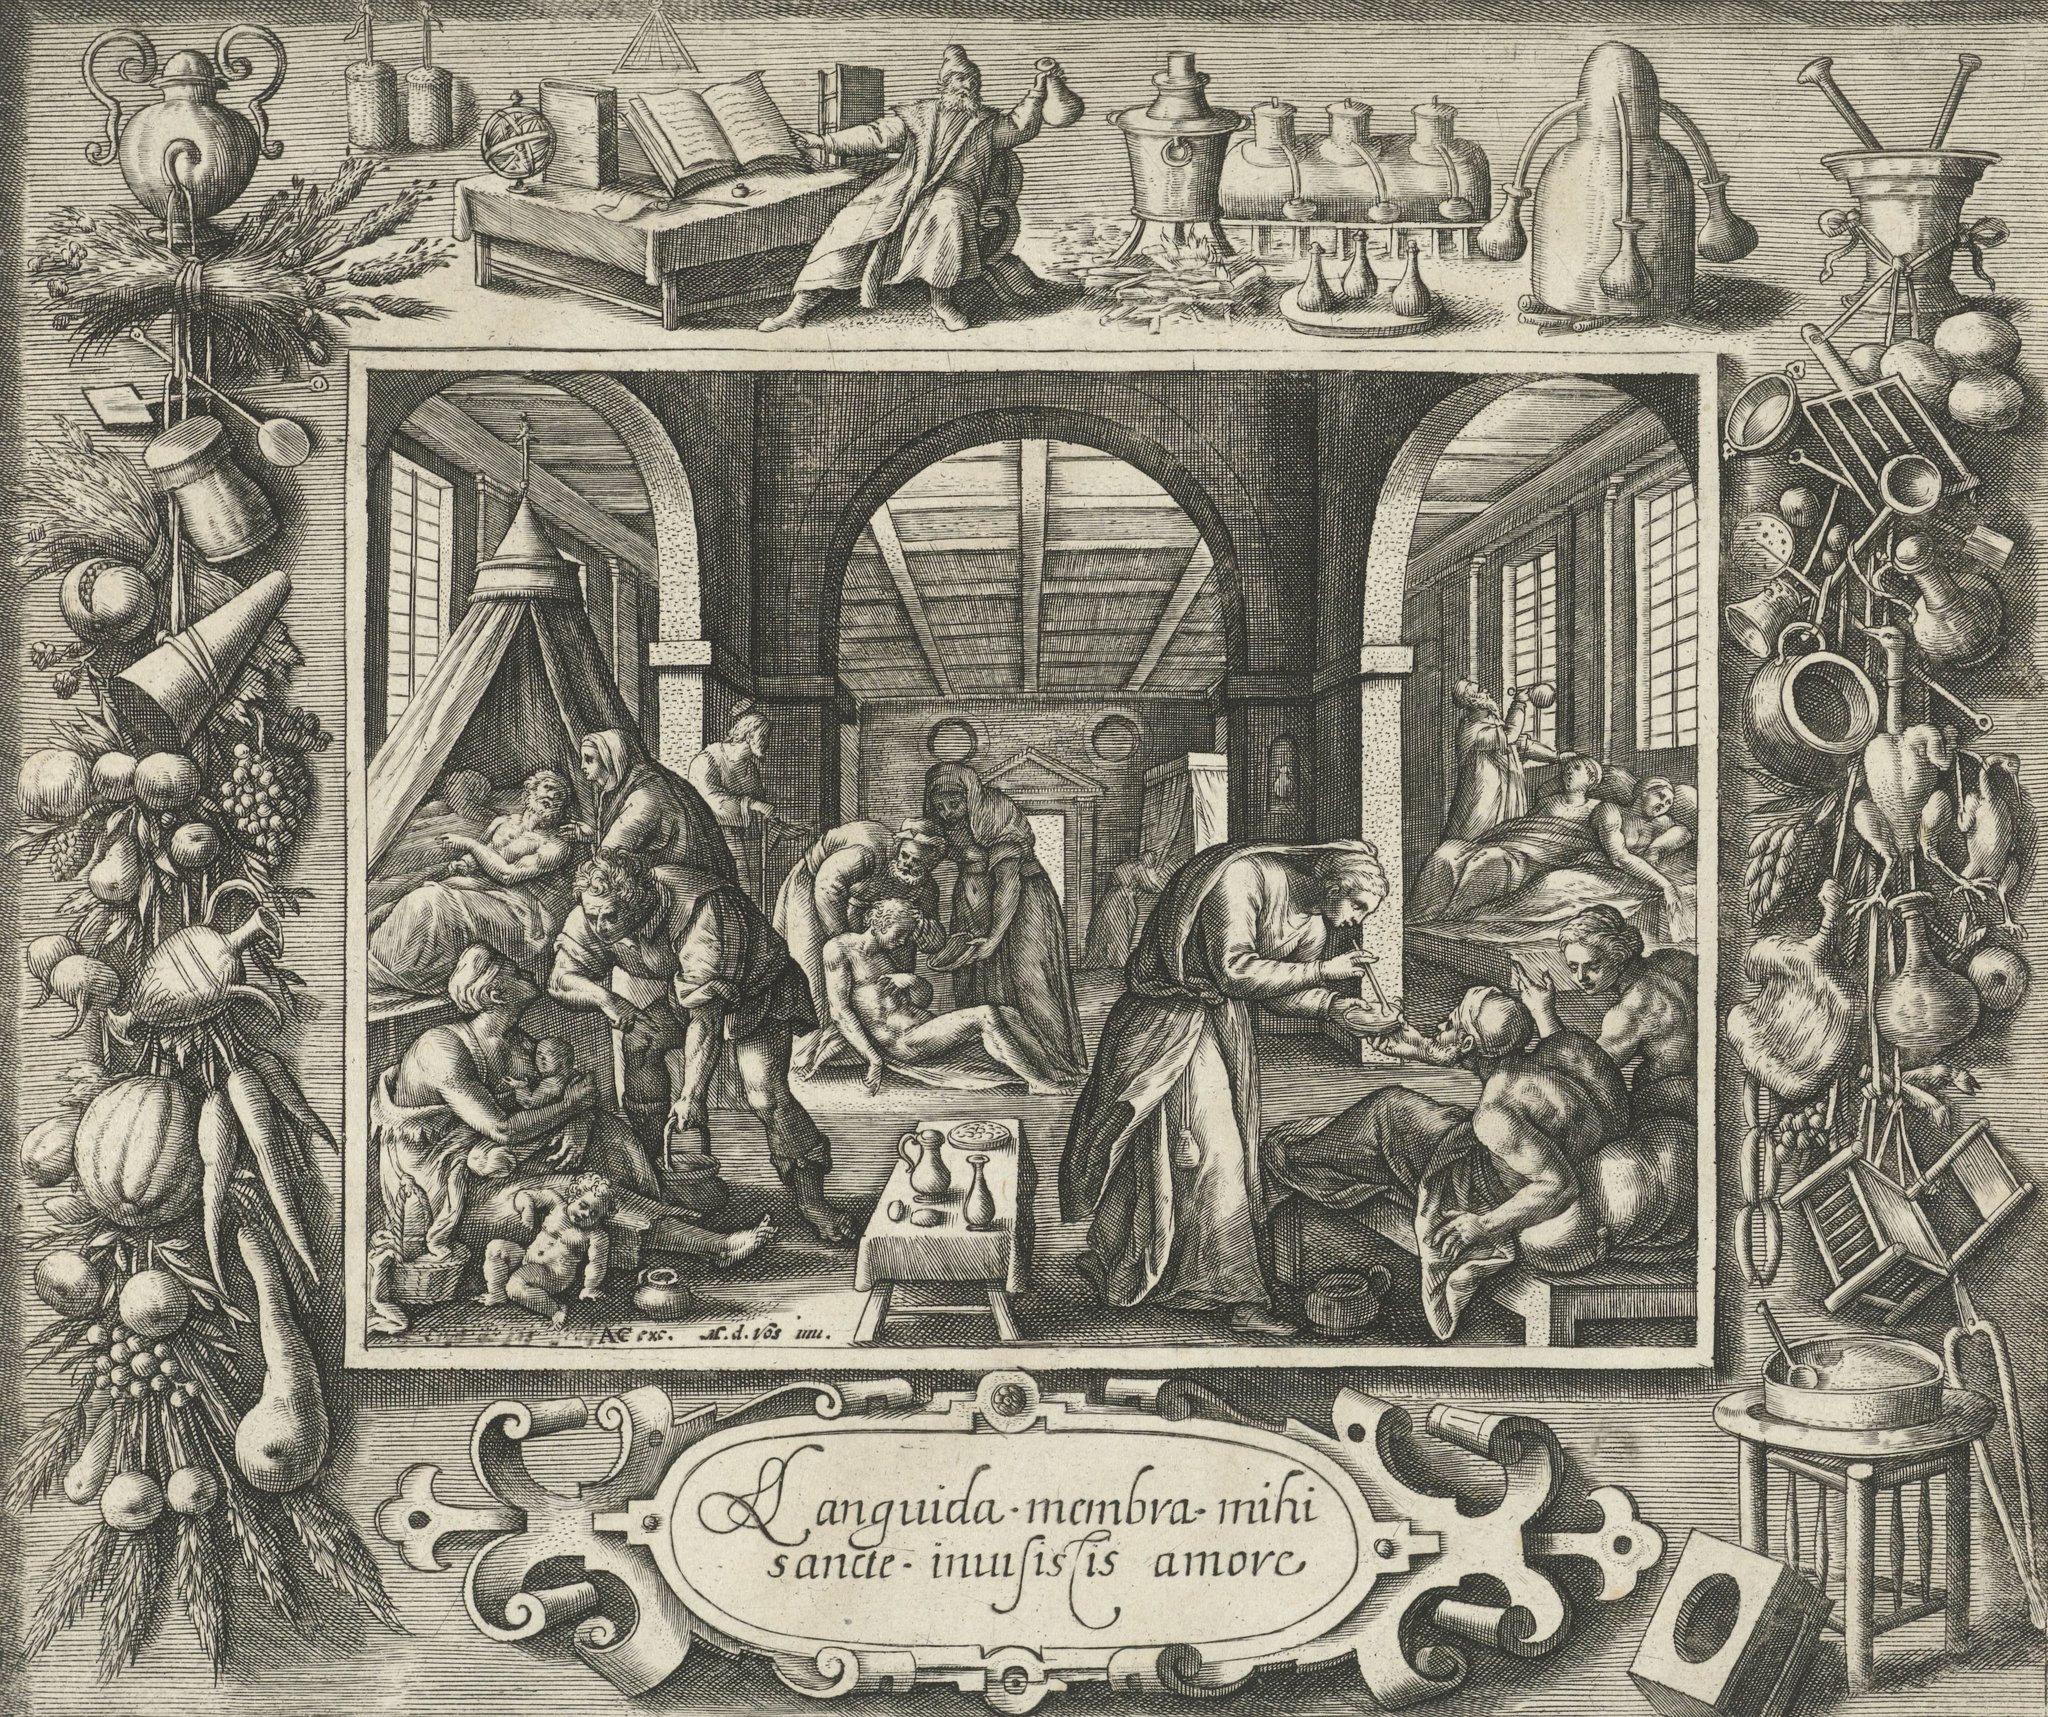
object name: print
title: Het Laatste Oordeel en de zeven werken van barmhartigheid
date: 1580-1588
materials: paper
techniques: engraving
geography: antwerp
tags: pharmacist, druggist, apothecary; pharmacy, drugstore, dispensing chemist, visiting the sick, 'aeger curatur' ~ one of the (seven) acts of mercy, medicament, medicine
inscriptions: collector's mark: Lugt 240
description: Interieur met mannen en vrouwen die ziek op bed liggen en een vrouw die haar kind zoogt. Vrouwen die aan de bedden staan verzorgen de zieken met eten en drinken. De prent heeft een ornamentele rand die is versierd met alle benodigdheden voor en het maken van medicijnen. Prent uit een serie van acht met het Laatste Oordeel en de zeven werken van barmhartigheid.